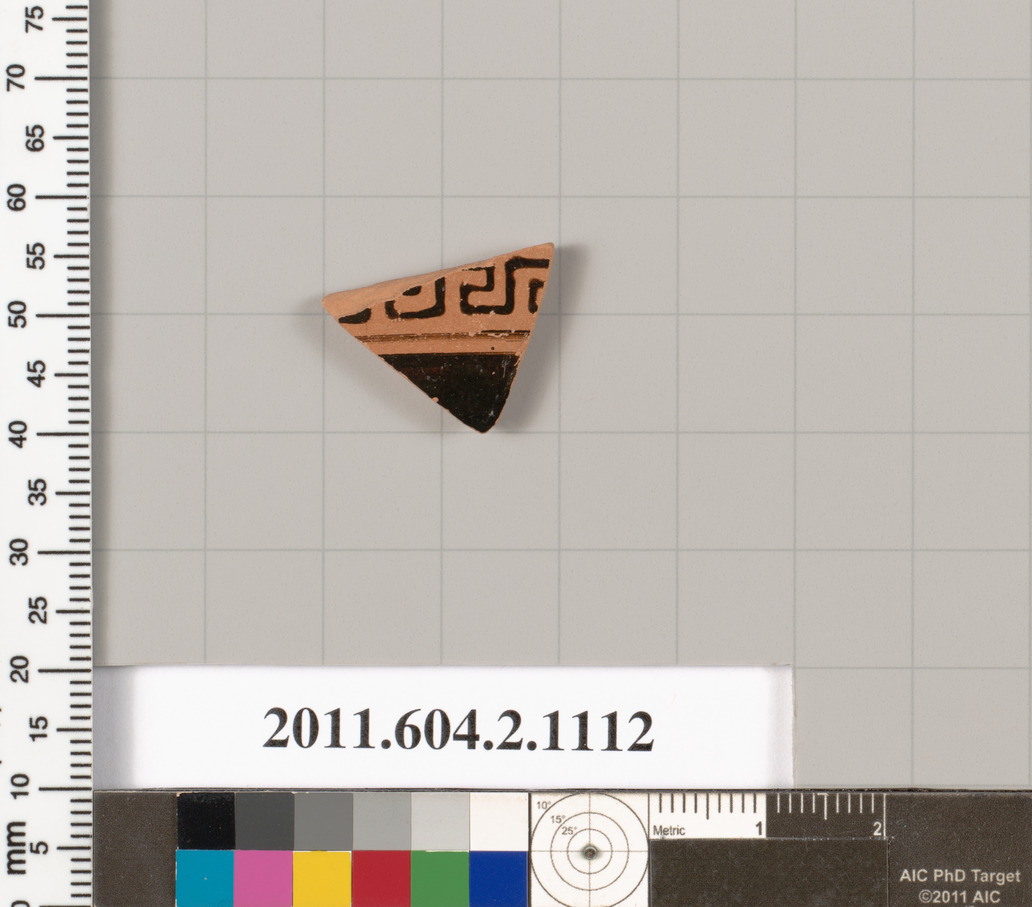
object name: lekythos fragment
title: Terracotta fragment of a lekythos (oil flask)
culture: greek, attic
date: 475-451 BCE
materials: terracotta